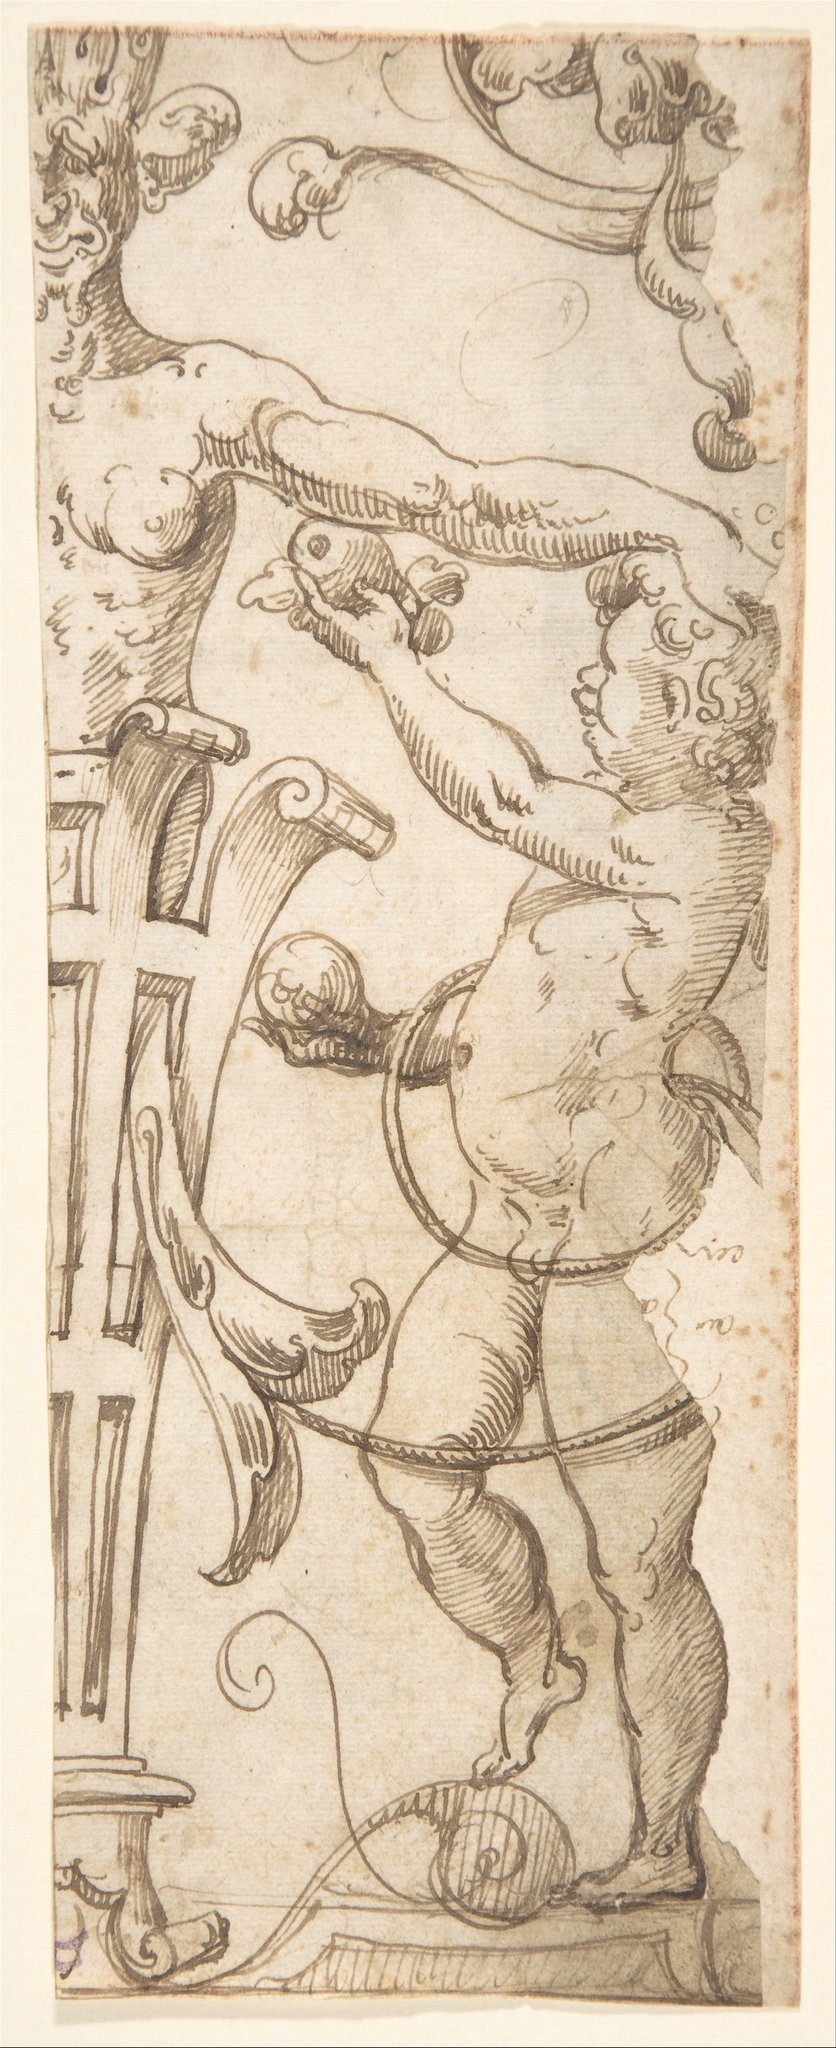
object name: drawing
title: Fragment of a Grotesque Decoration with a Term and Putto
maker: andrés de melgar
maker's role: artist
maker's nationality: spanish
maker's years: 1554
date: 1545-1560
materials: chalk, ink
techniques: brush, pen, wash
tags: grotesques,ornament,putti